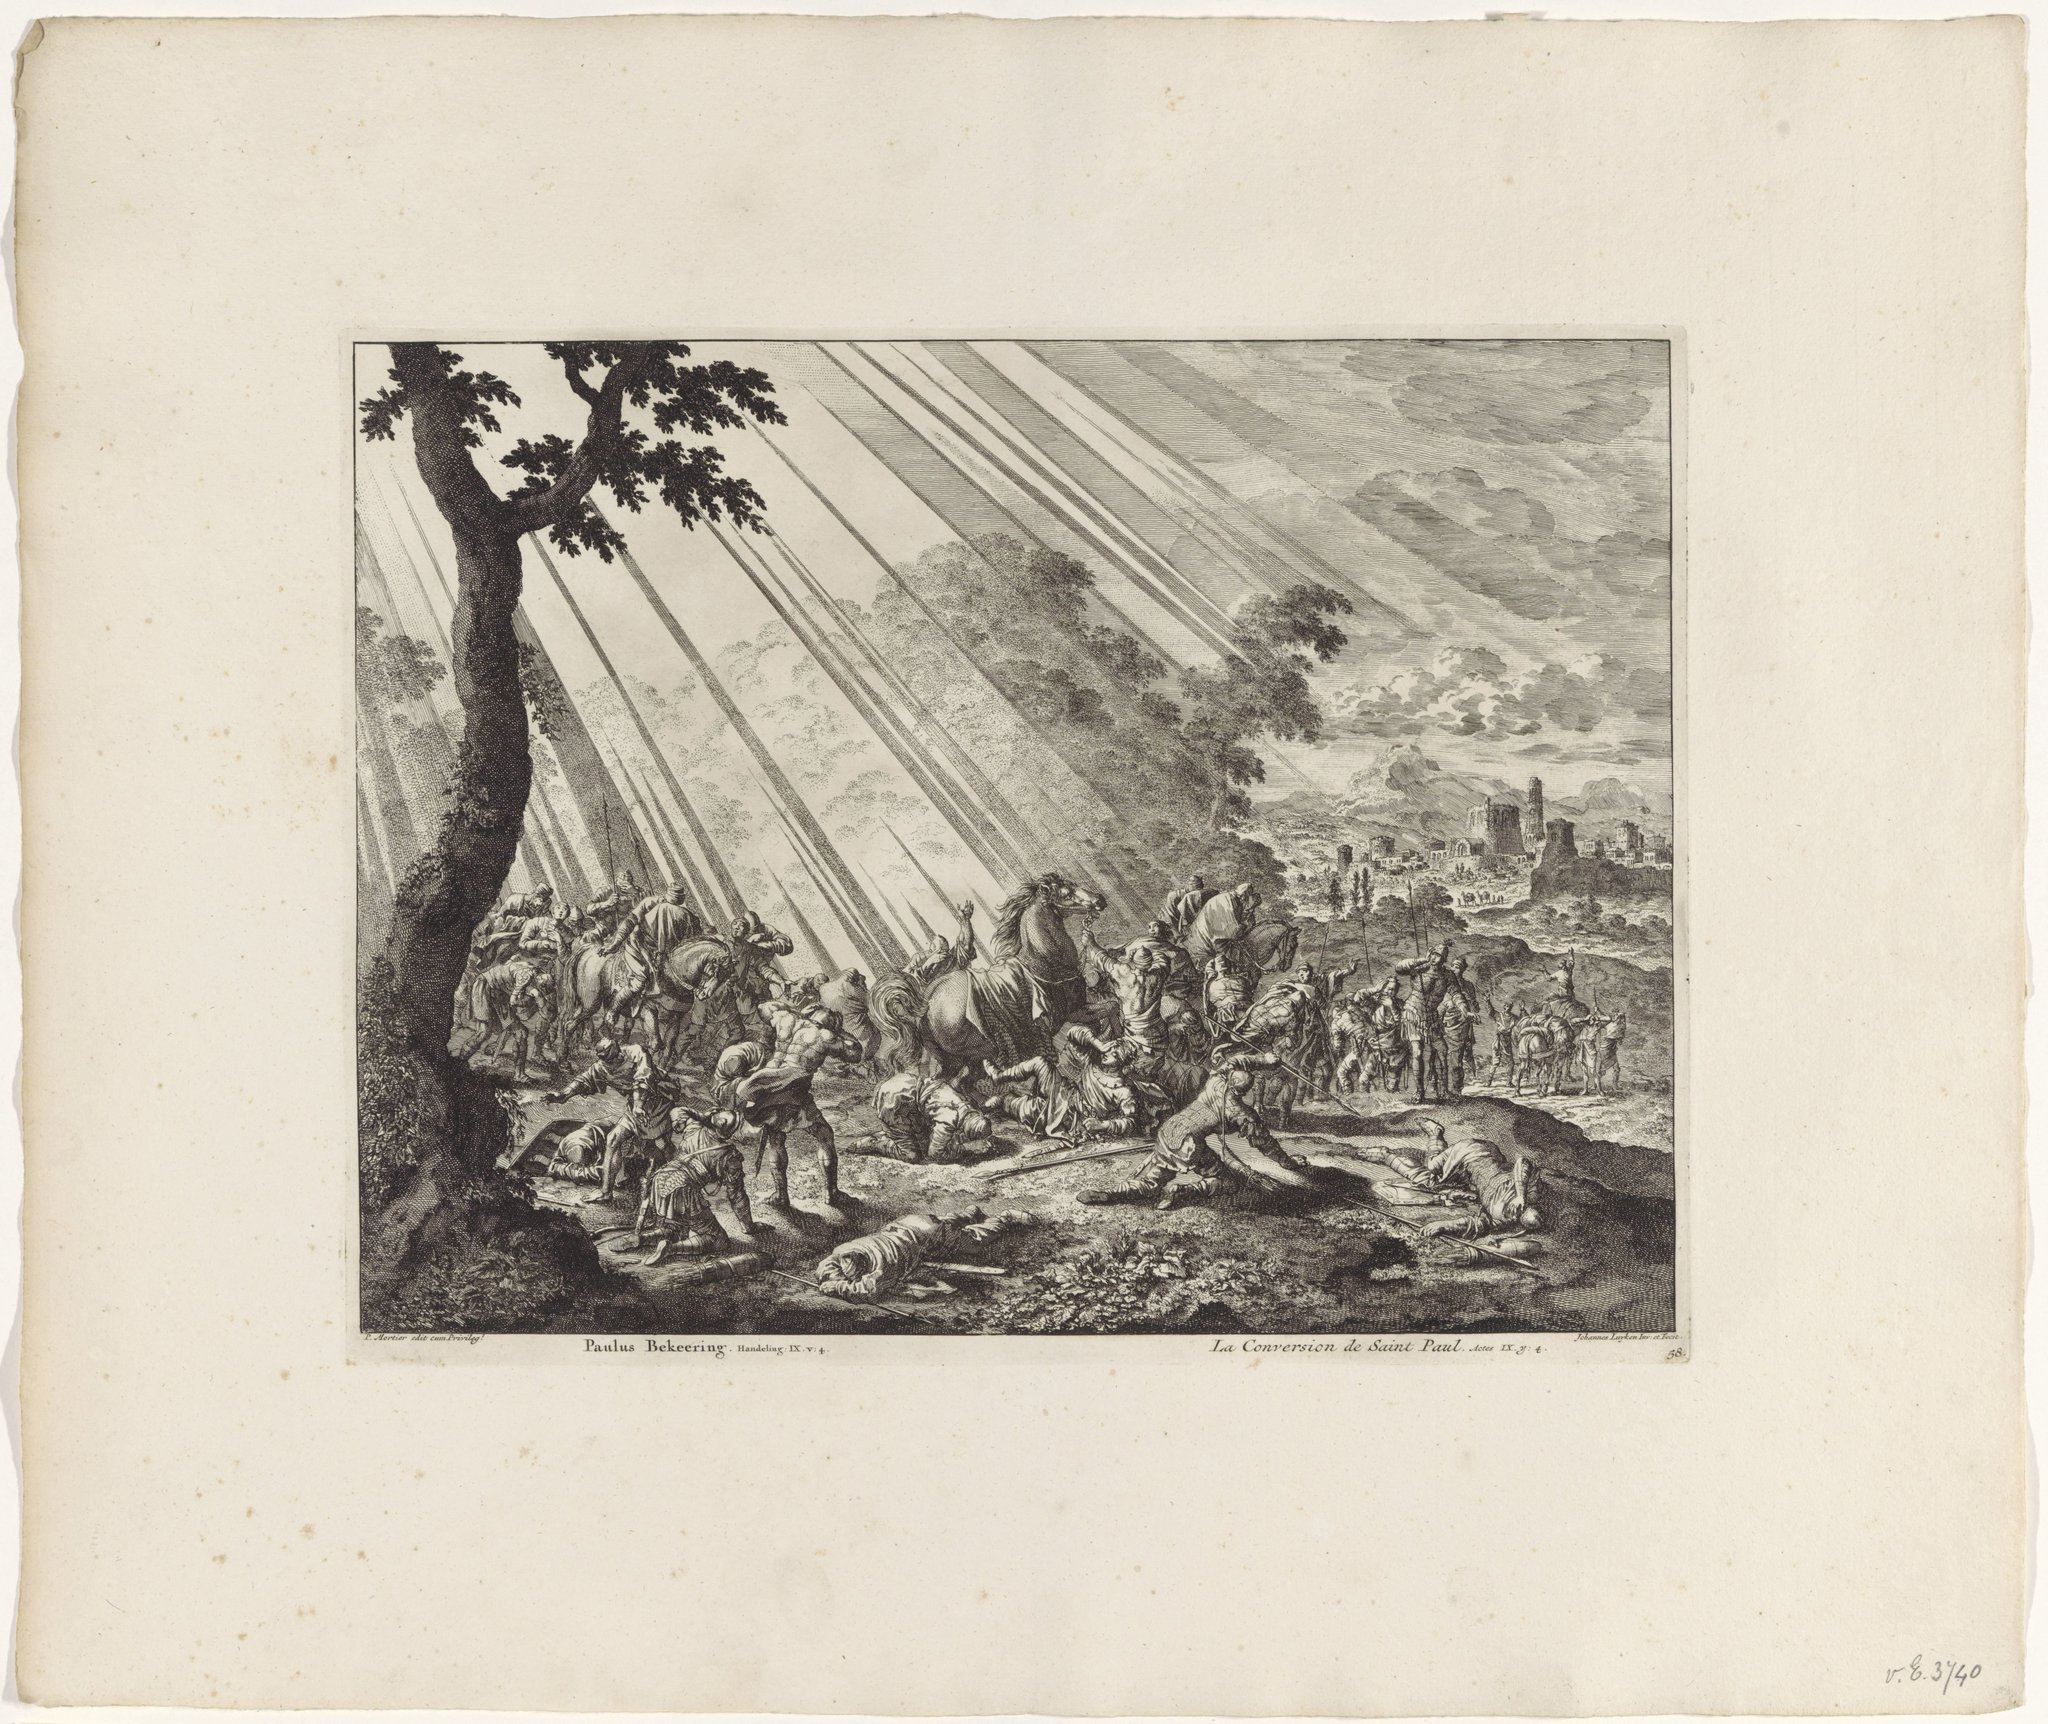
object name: print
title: Paulus Bekeering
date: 1708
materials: paper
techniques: etching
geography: amsterdam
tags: on the way to damascus christ appears to saul, who falls from his horse and is blinded by the light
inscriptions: collector's mark: Lugt 2228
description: Paulus is te paard op weg naar Damascus als hij wordt verblind door een licht uit de hemel waar Christus verschijnt. Zijn paard steigert en zijn hoed en tas vallen op de grond. De soldaten die samen met Paulus onderweg zijn wenden hun gezicht van het licht af.